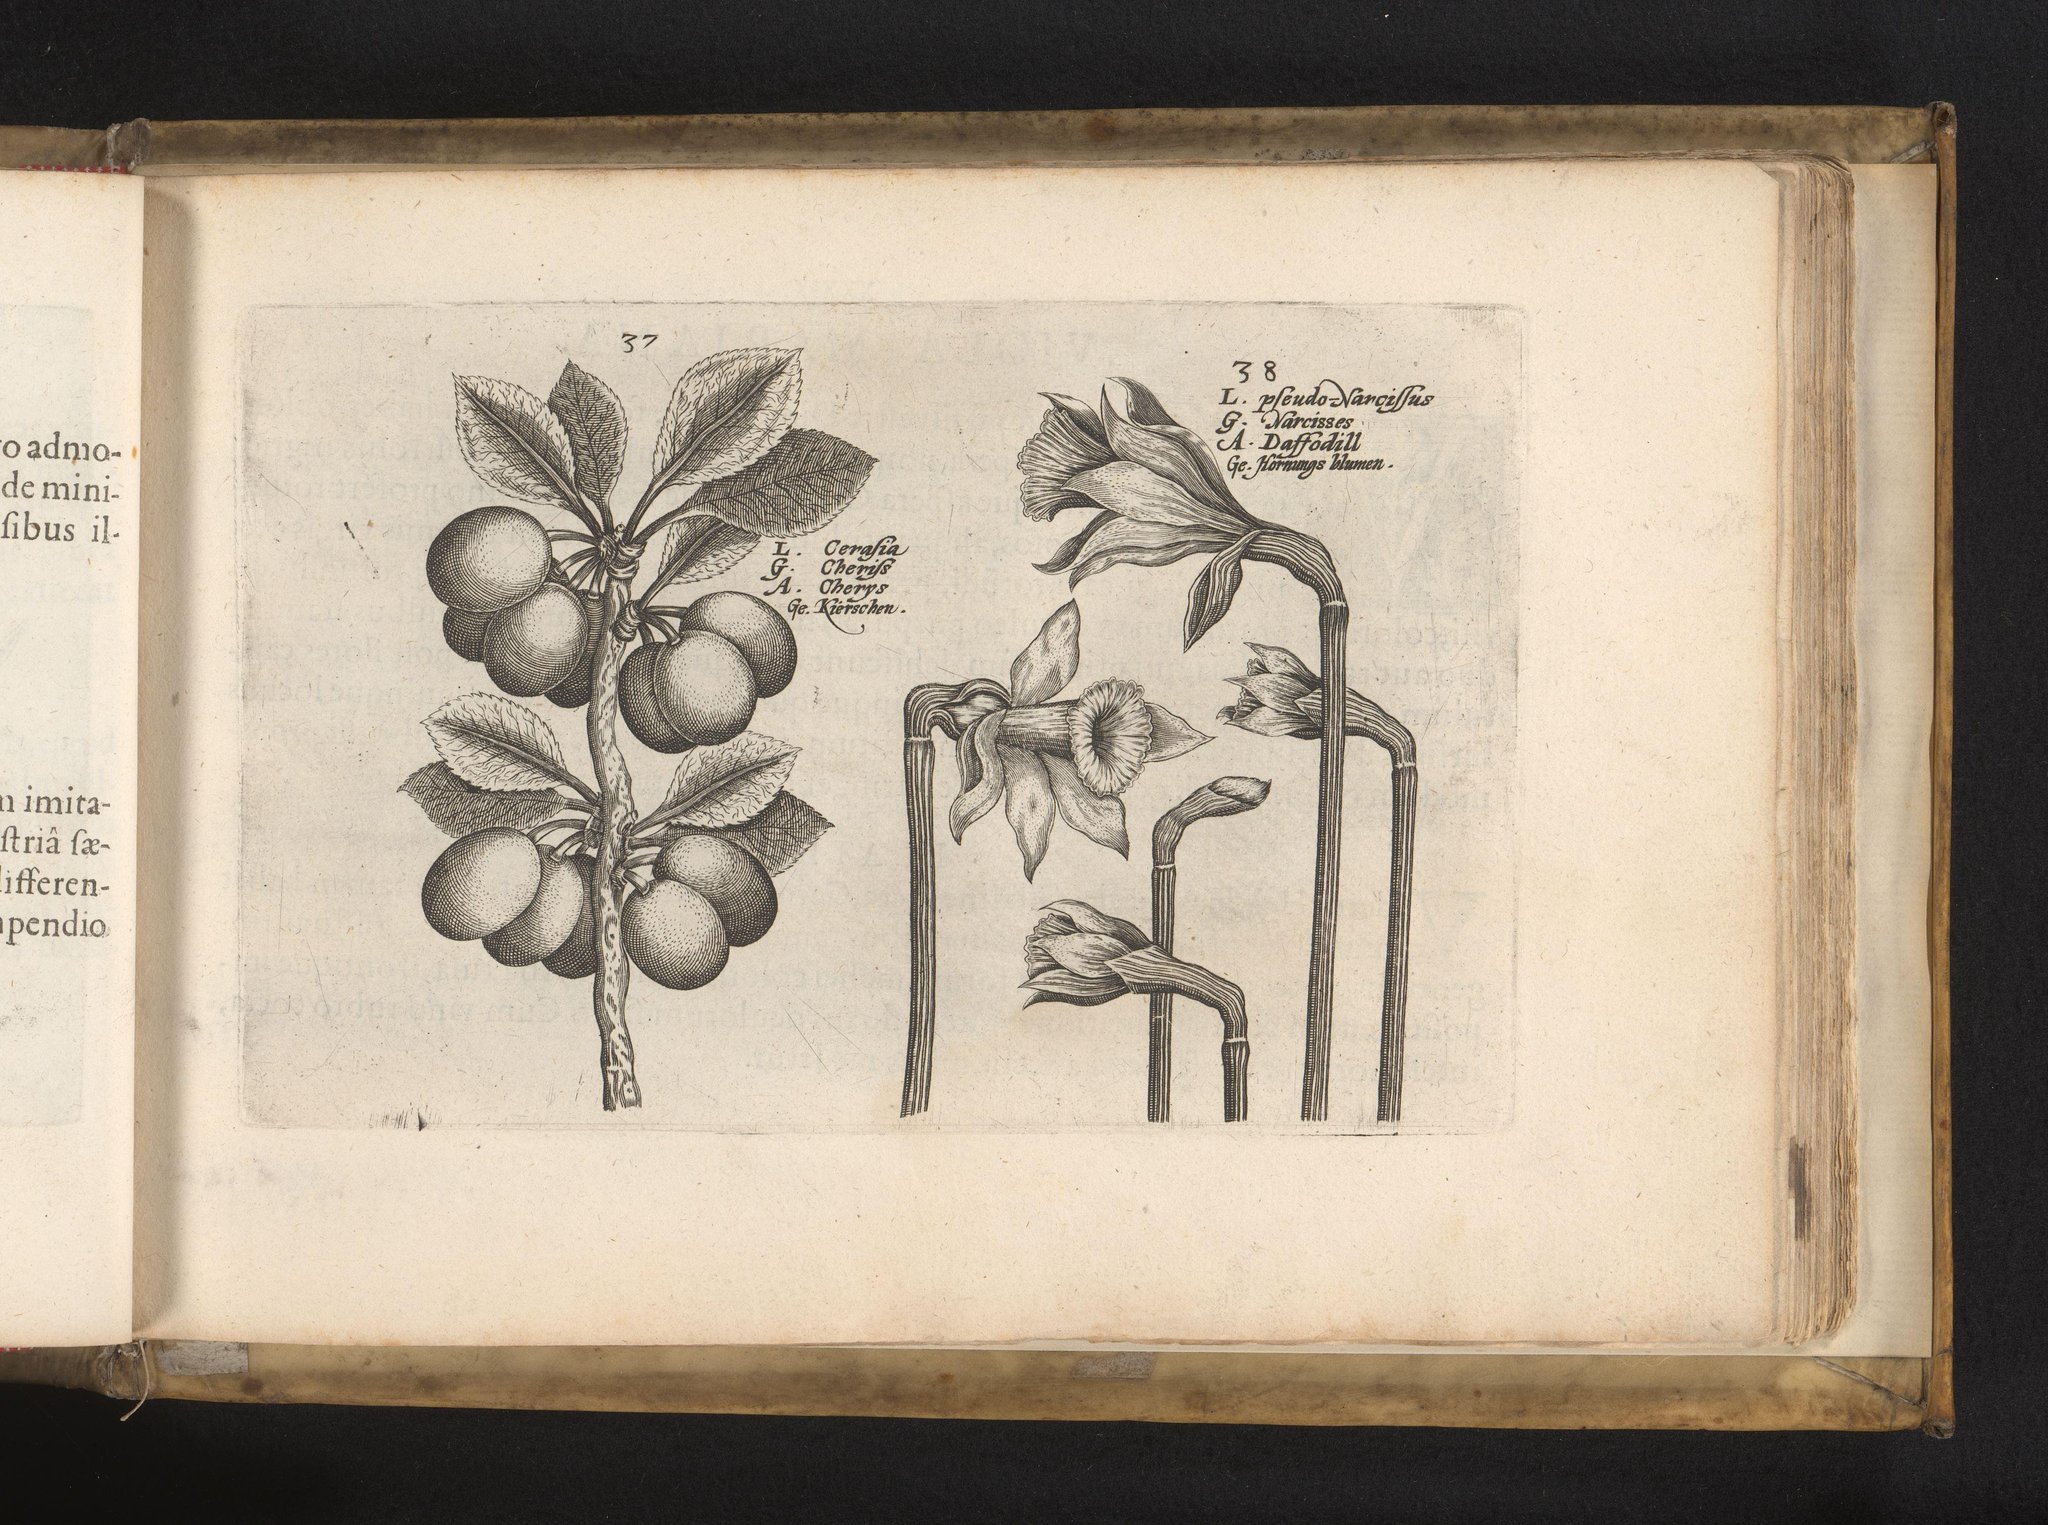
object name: page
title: Cerasia / Cheriss / Cherys / Kierschen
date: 1617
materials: paper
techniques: engraving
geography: arnhem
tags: flowers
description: Prent uit: Passe, Crispijn van de (II). Hortus floridus in quo rariorum & minus vulgarium florum icones ad vivam veramque formam. Arnhem: Johannes Janssonius, 1617.